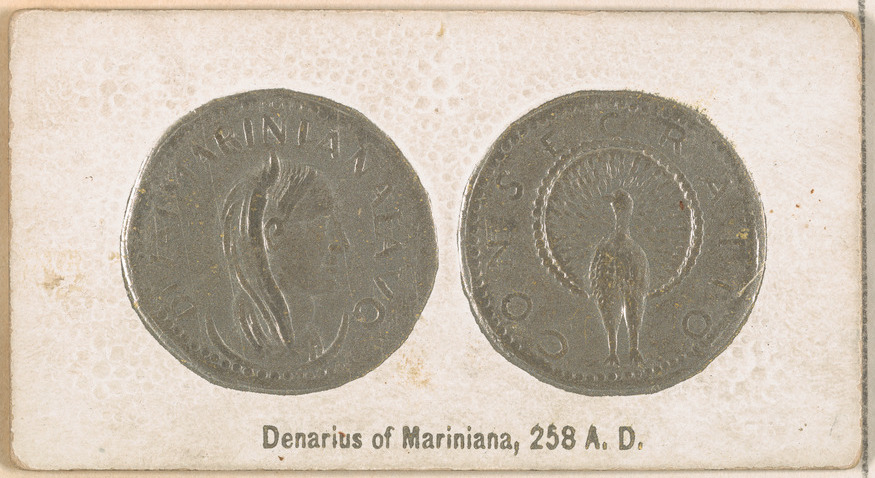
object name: print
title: Denarius of Mariniana, 258 A.D., from the Ancient Coins series (N180) issued by Wm. S. Kimball & Co.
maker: william s. kimball & company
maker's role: publisher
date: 1888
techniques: color lithograph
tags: coins